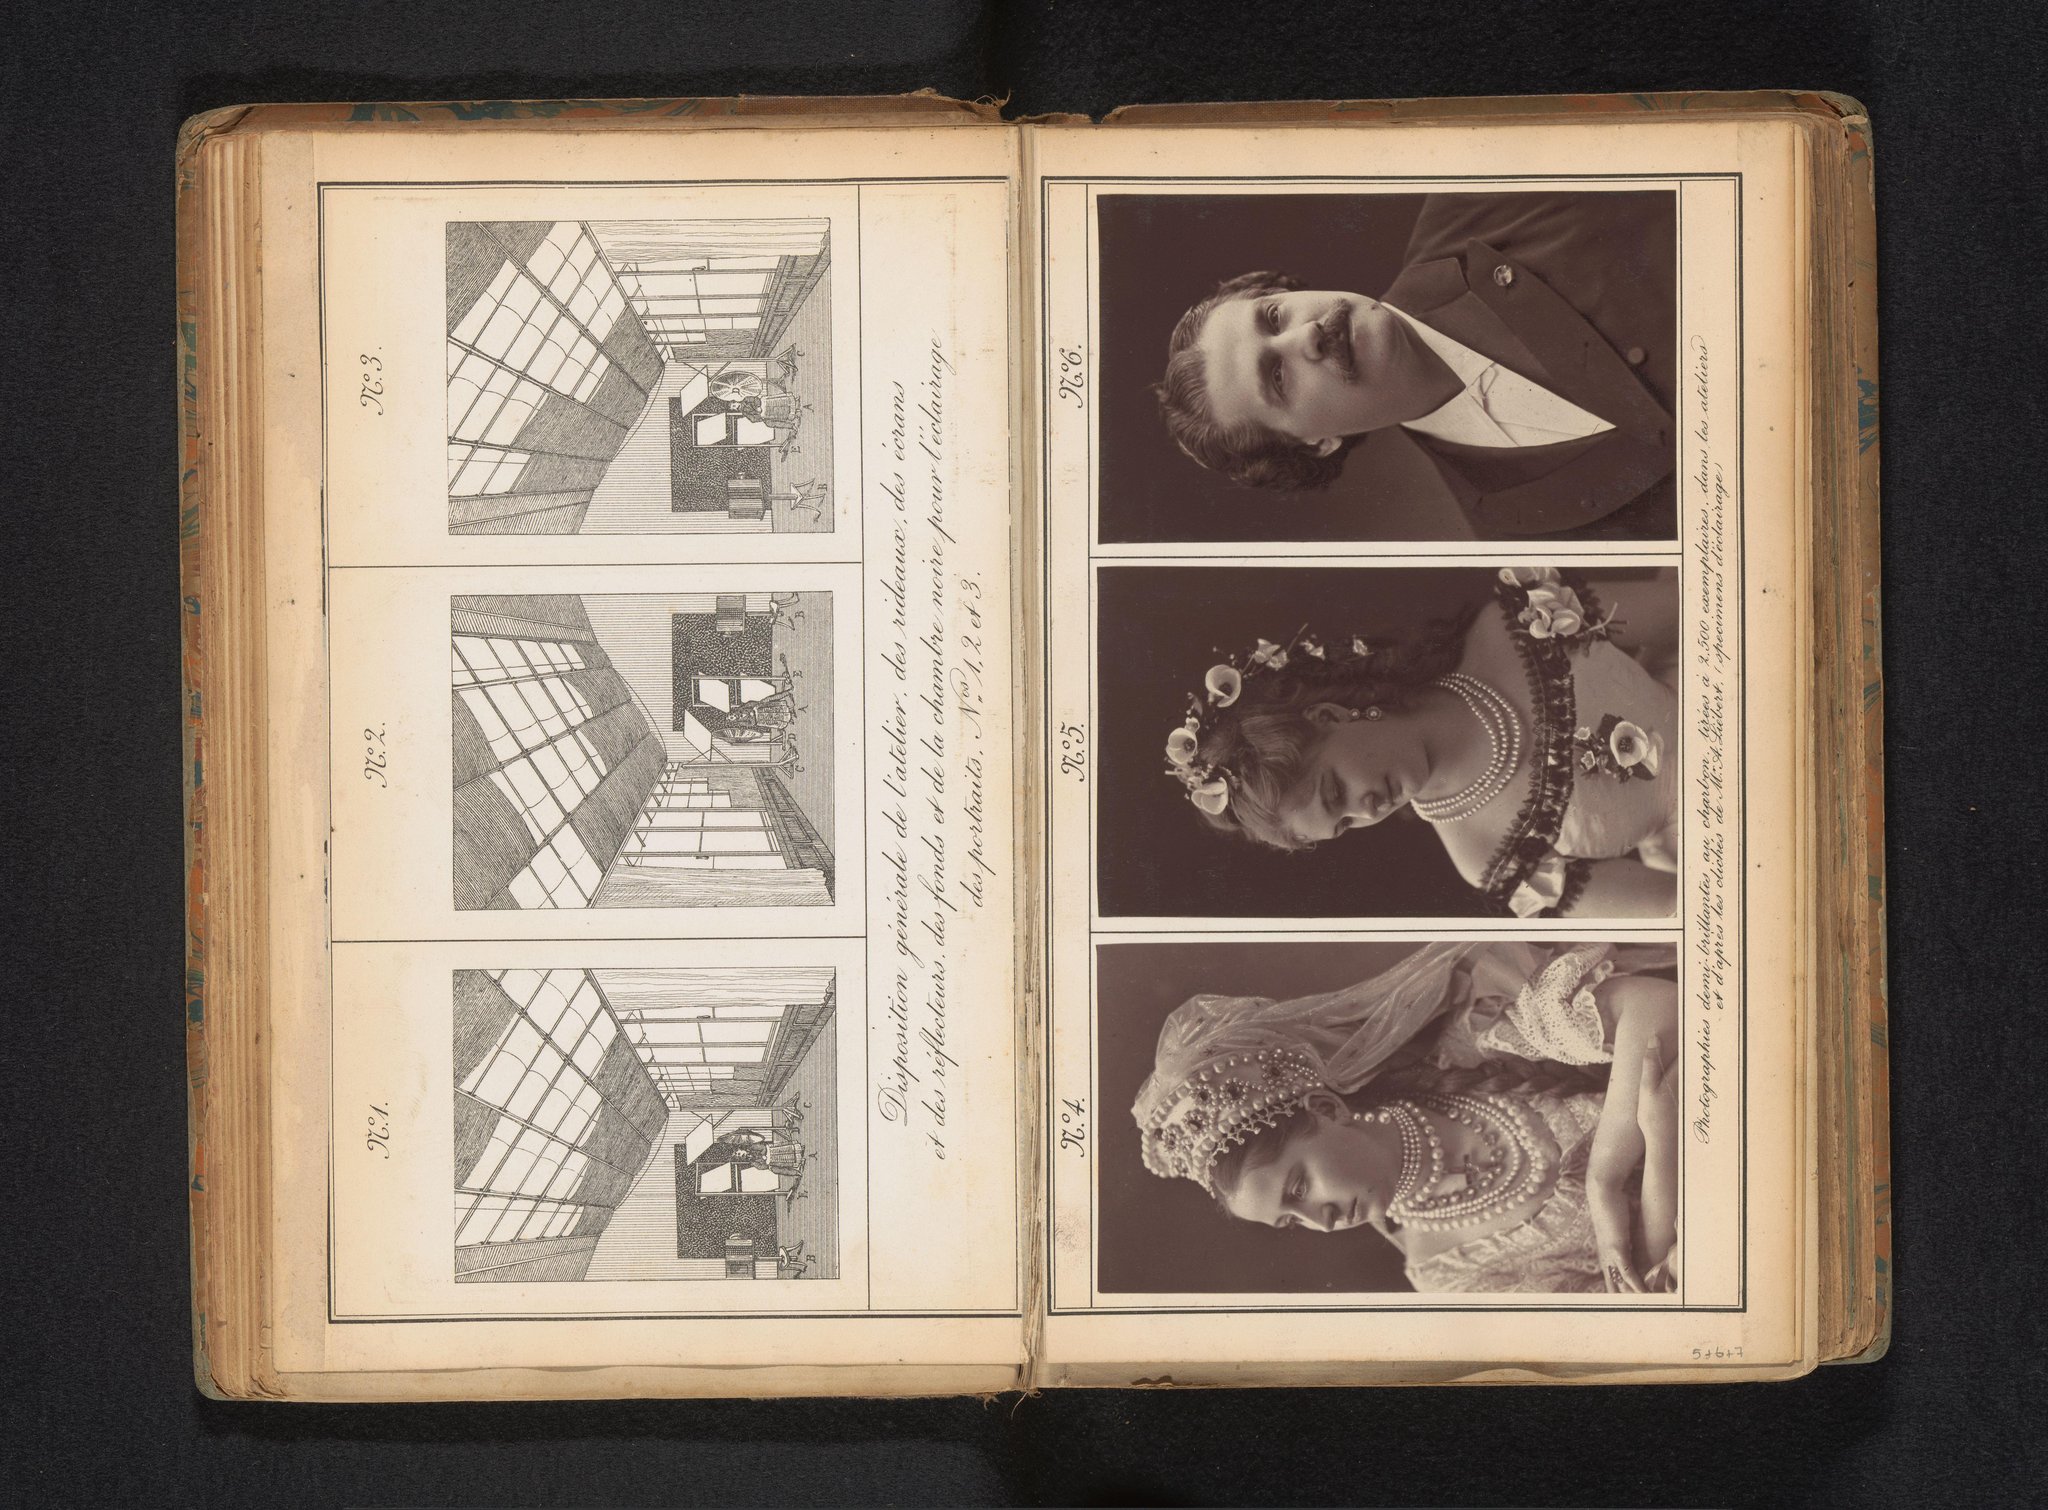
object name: page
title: Belichtingsstudie, afgebeeld een portret van een onbekende vrouw met bloemen in haar haren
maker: alphonse-justin liébert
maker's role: fotograaf, marinier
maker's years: 1827-1914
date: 1873-1878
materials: paper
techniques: carbon print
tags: garland, wreath, historical persons not known by name - bb - woman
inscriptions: number: ‘No. 5.’, inscription: ‘Photographies demi-brillantes au charbon, tirées à 2.500 exemplaires, dans les ateliers/ et d'après les clichés de Mr. A. Liébert. (specimens d'éclairage)’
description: Foto op derde ongenummerde pagina na pagina 80.